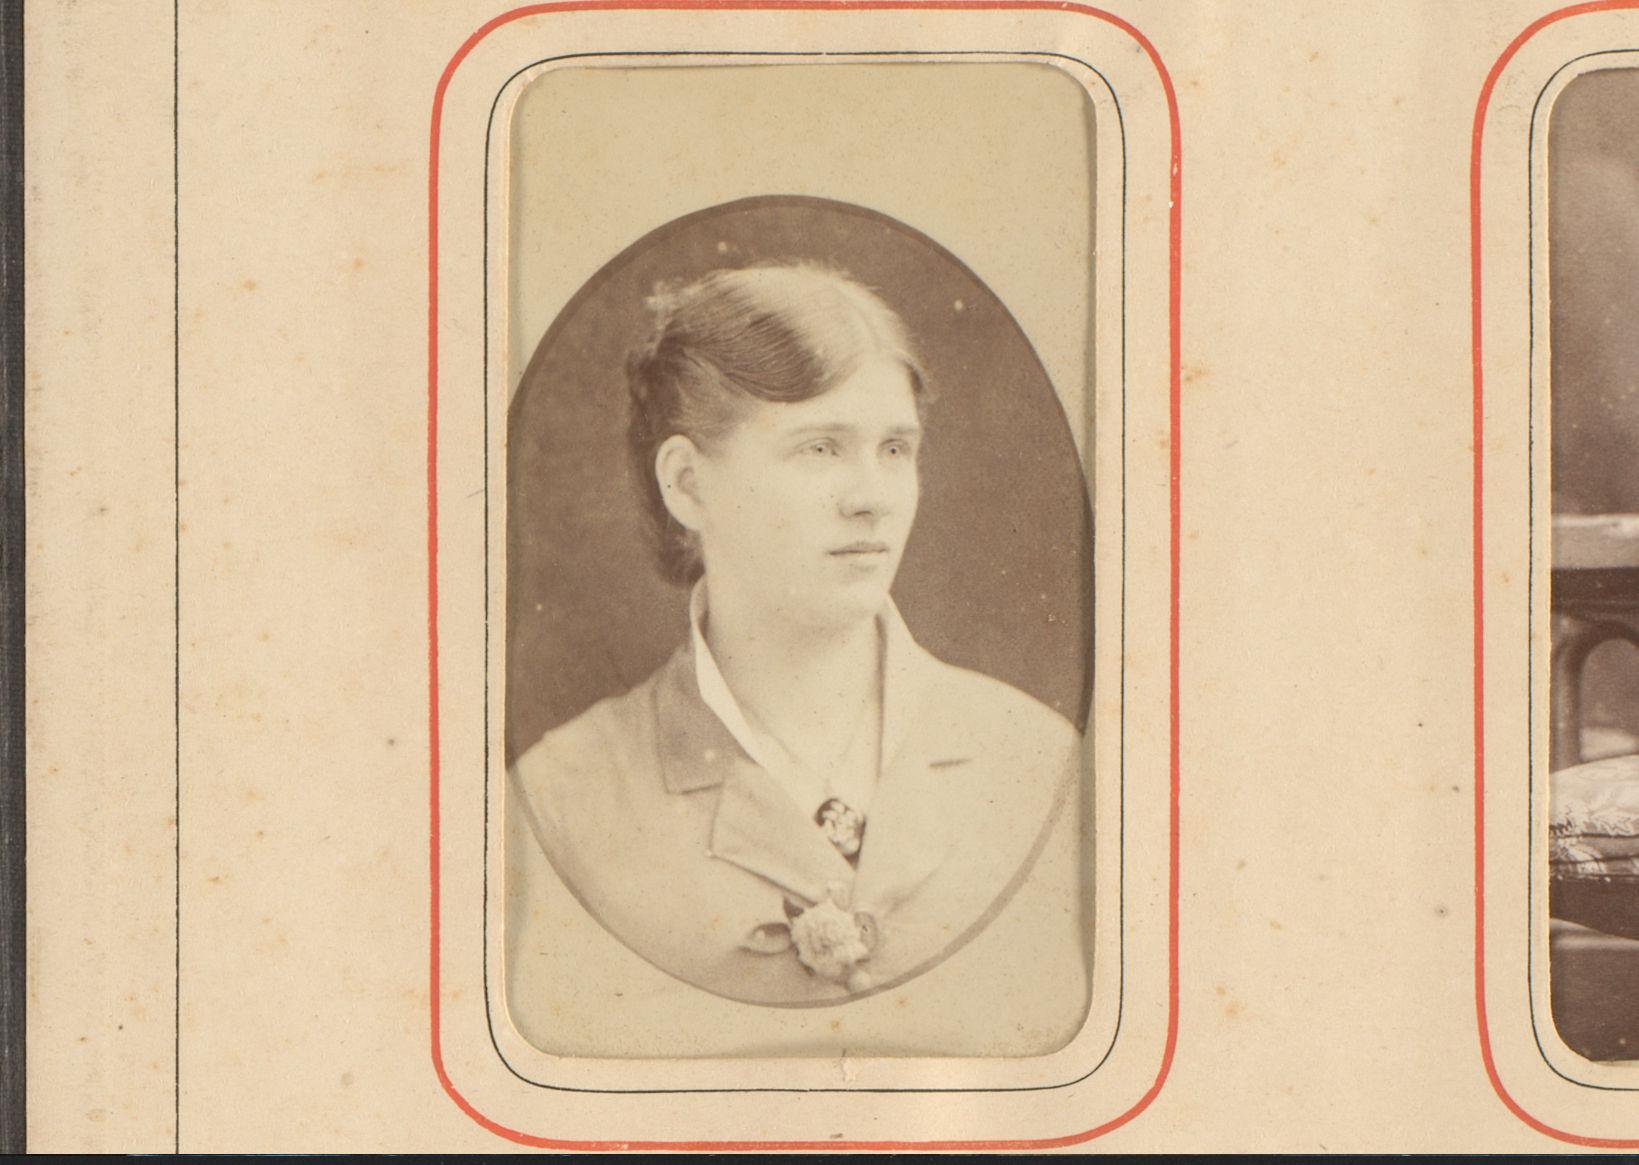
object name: album leaf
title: Portret van een onbekende vrouw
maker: isidore kinsbergen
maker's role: fotograaf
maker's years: 1821-1905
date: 1870-1890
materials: cardboard, paper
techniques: albumen print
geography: batavia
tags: anonymous historical person portrayed - bb - woman